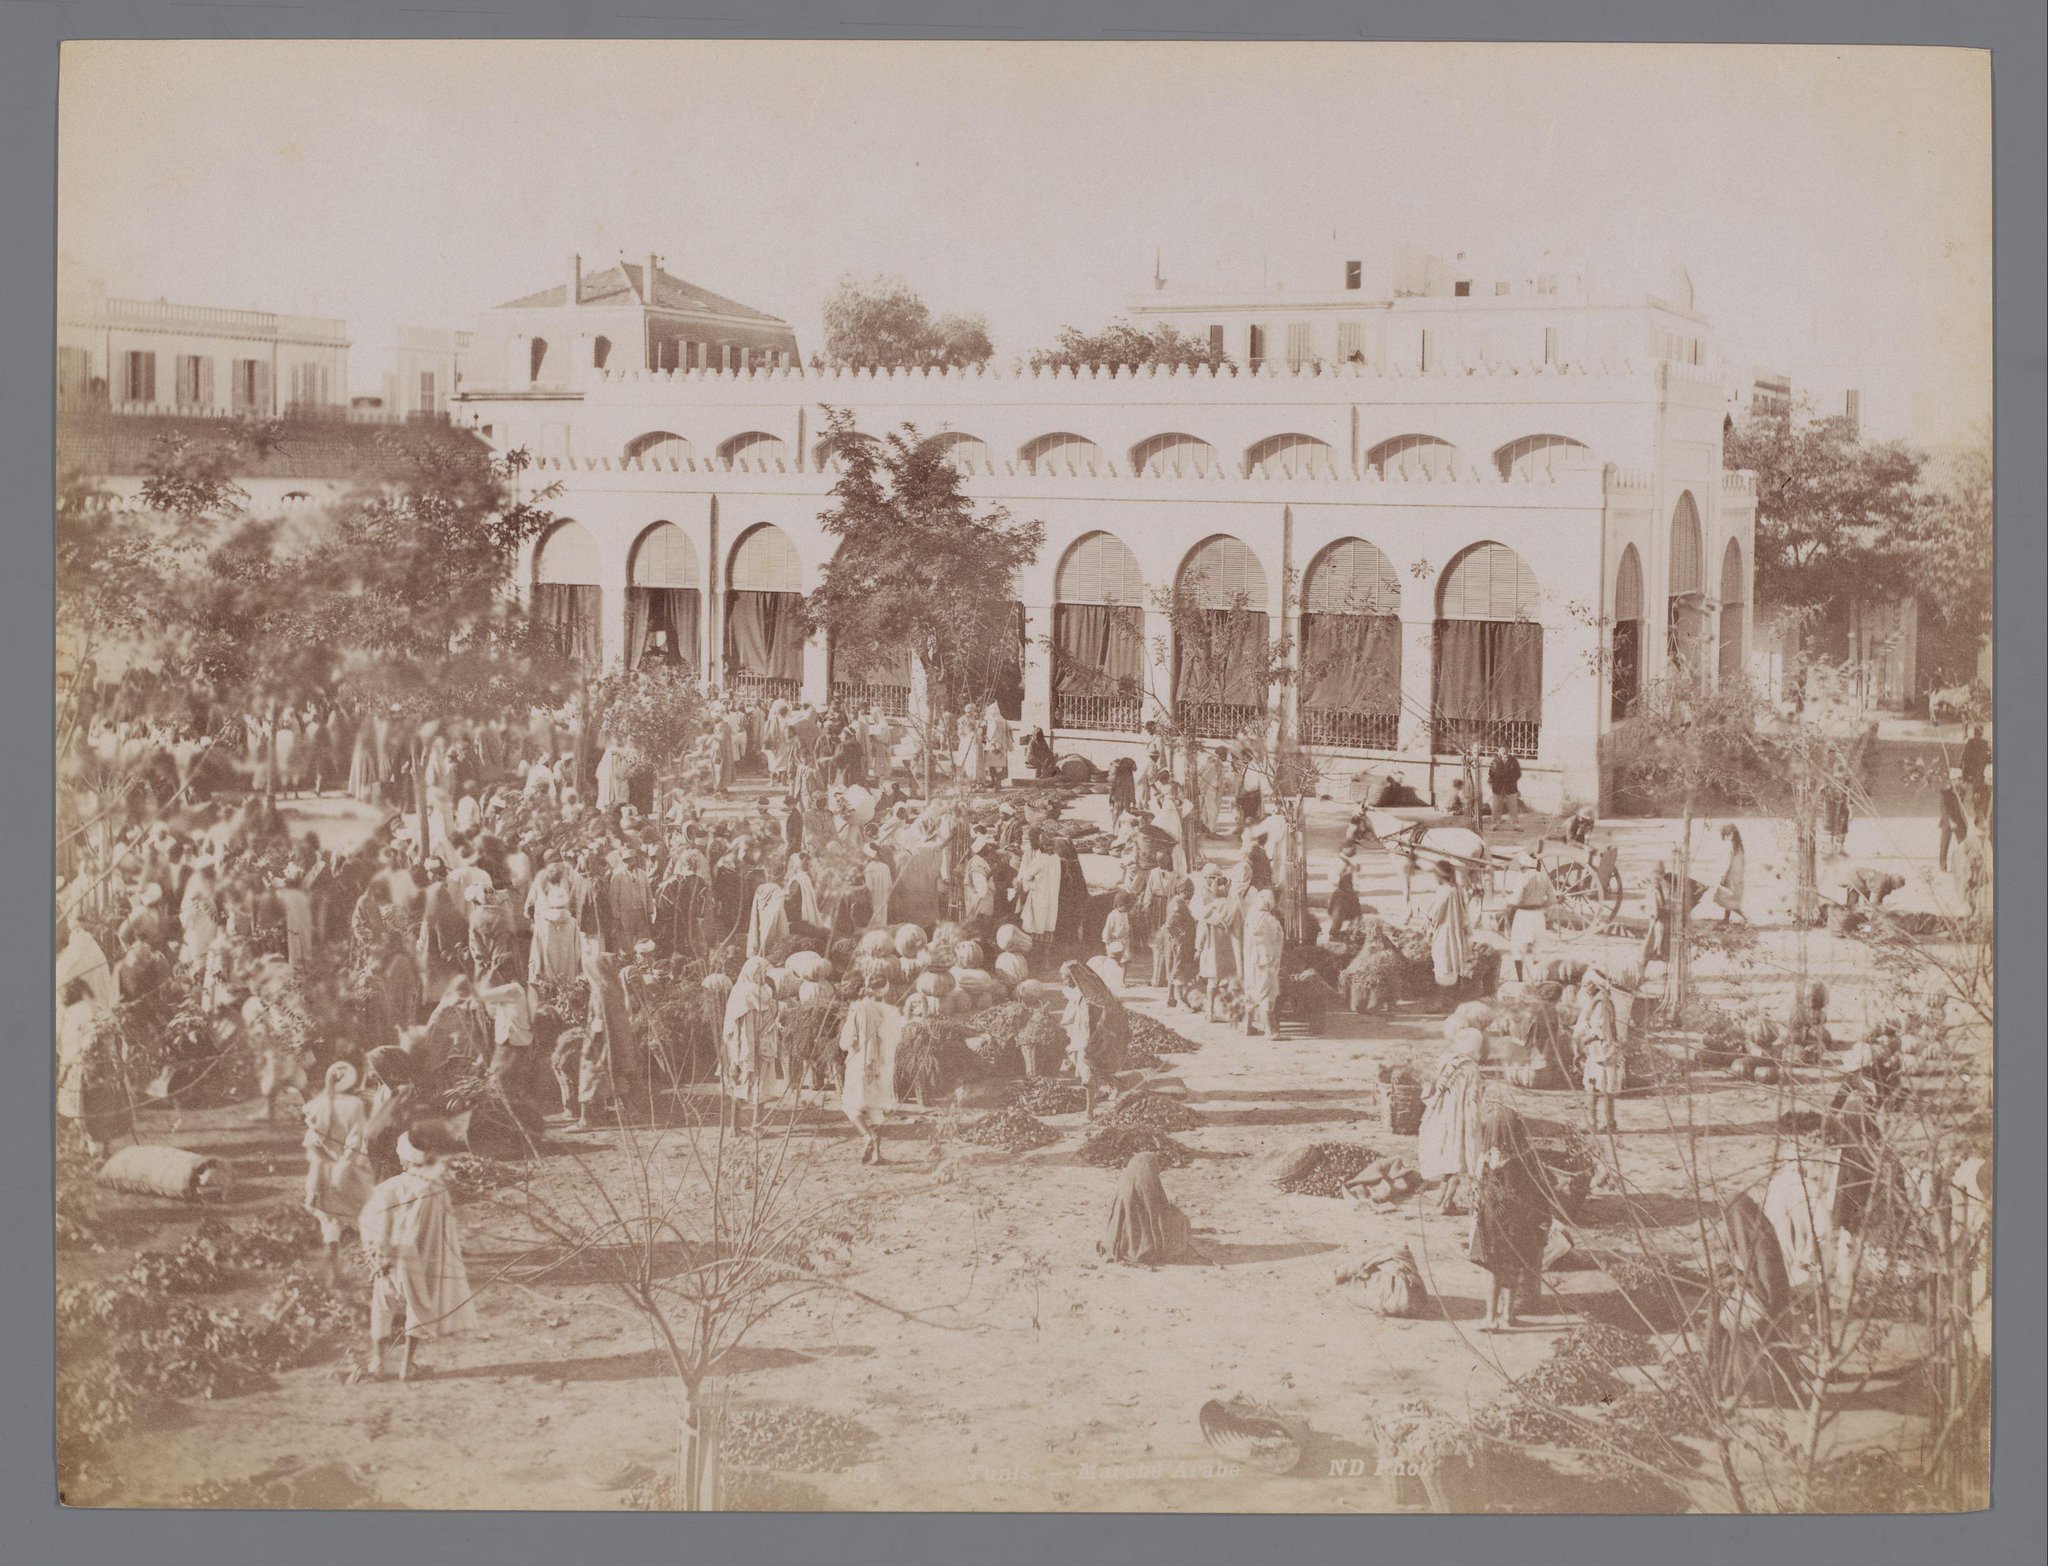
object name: photograph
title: Tunis, marché Arabe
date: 1863-1900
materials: paper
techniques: albumen print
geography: tunis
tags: market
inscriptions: number: ‘354’